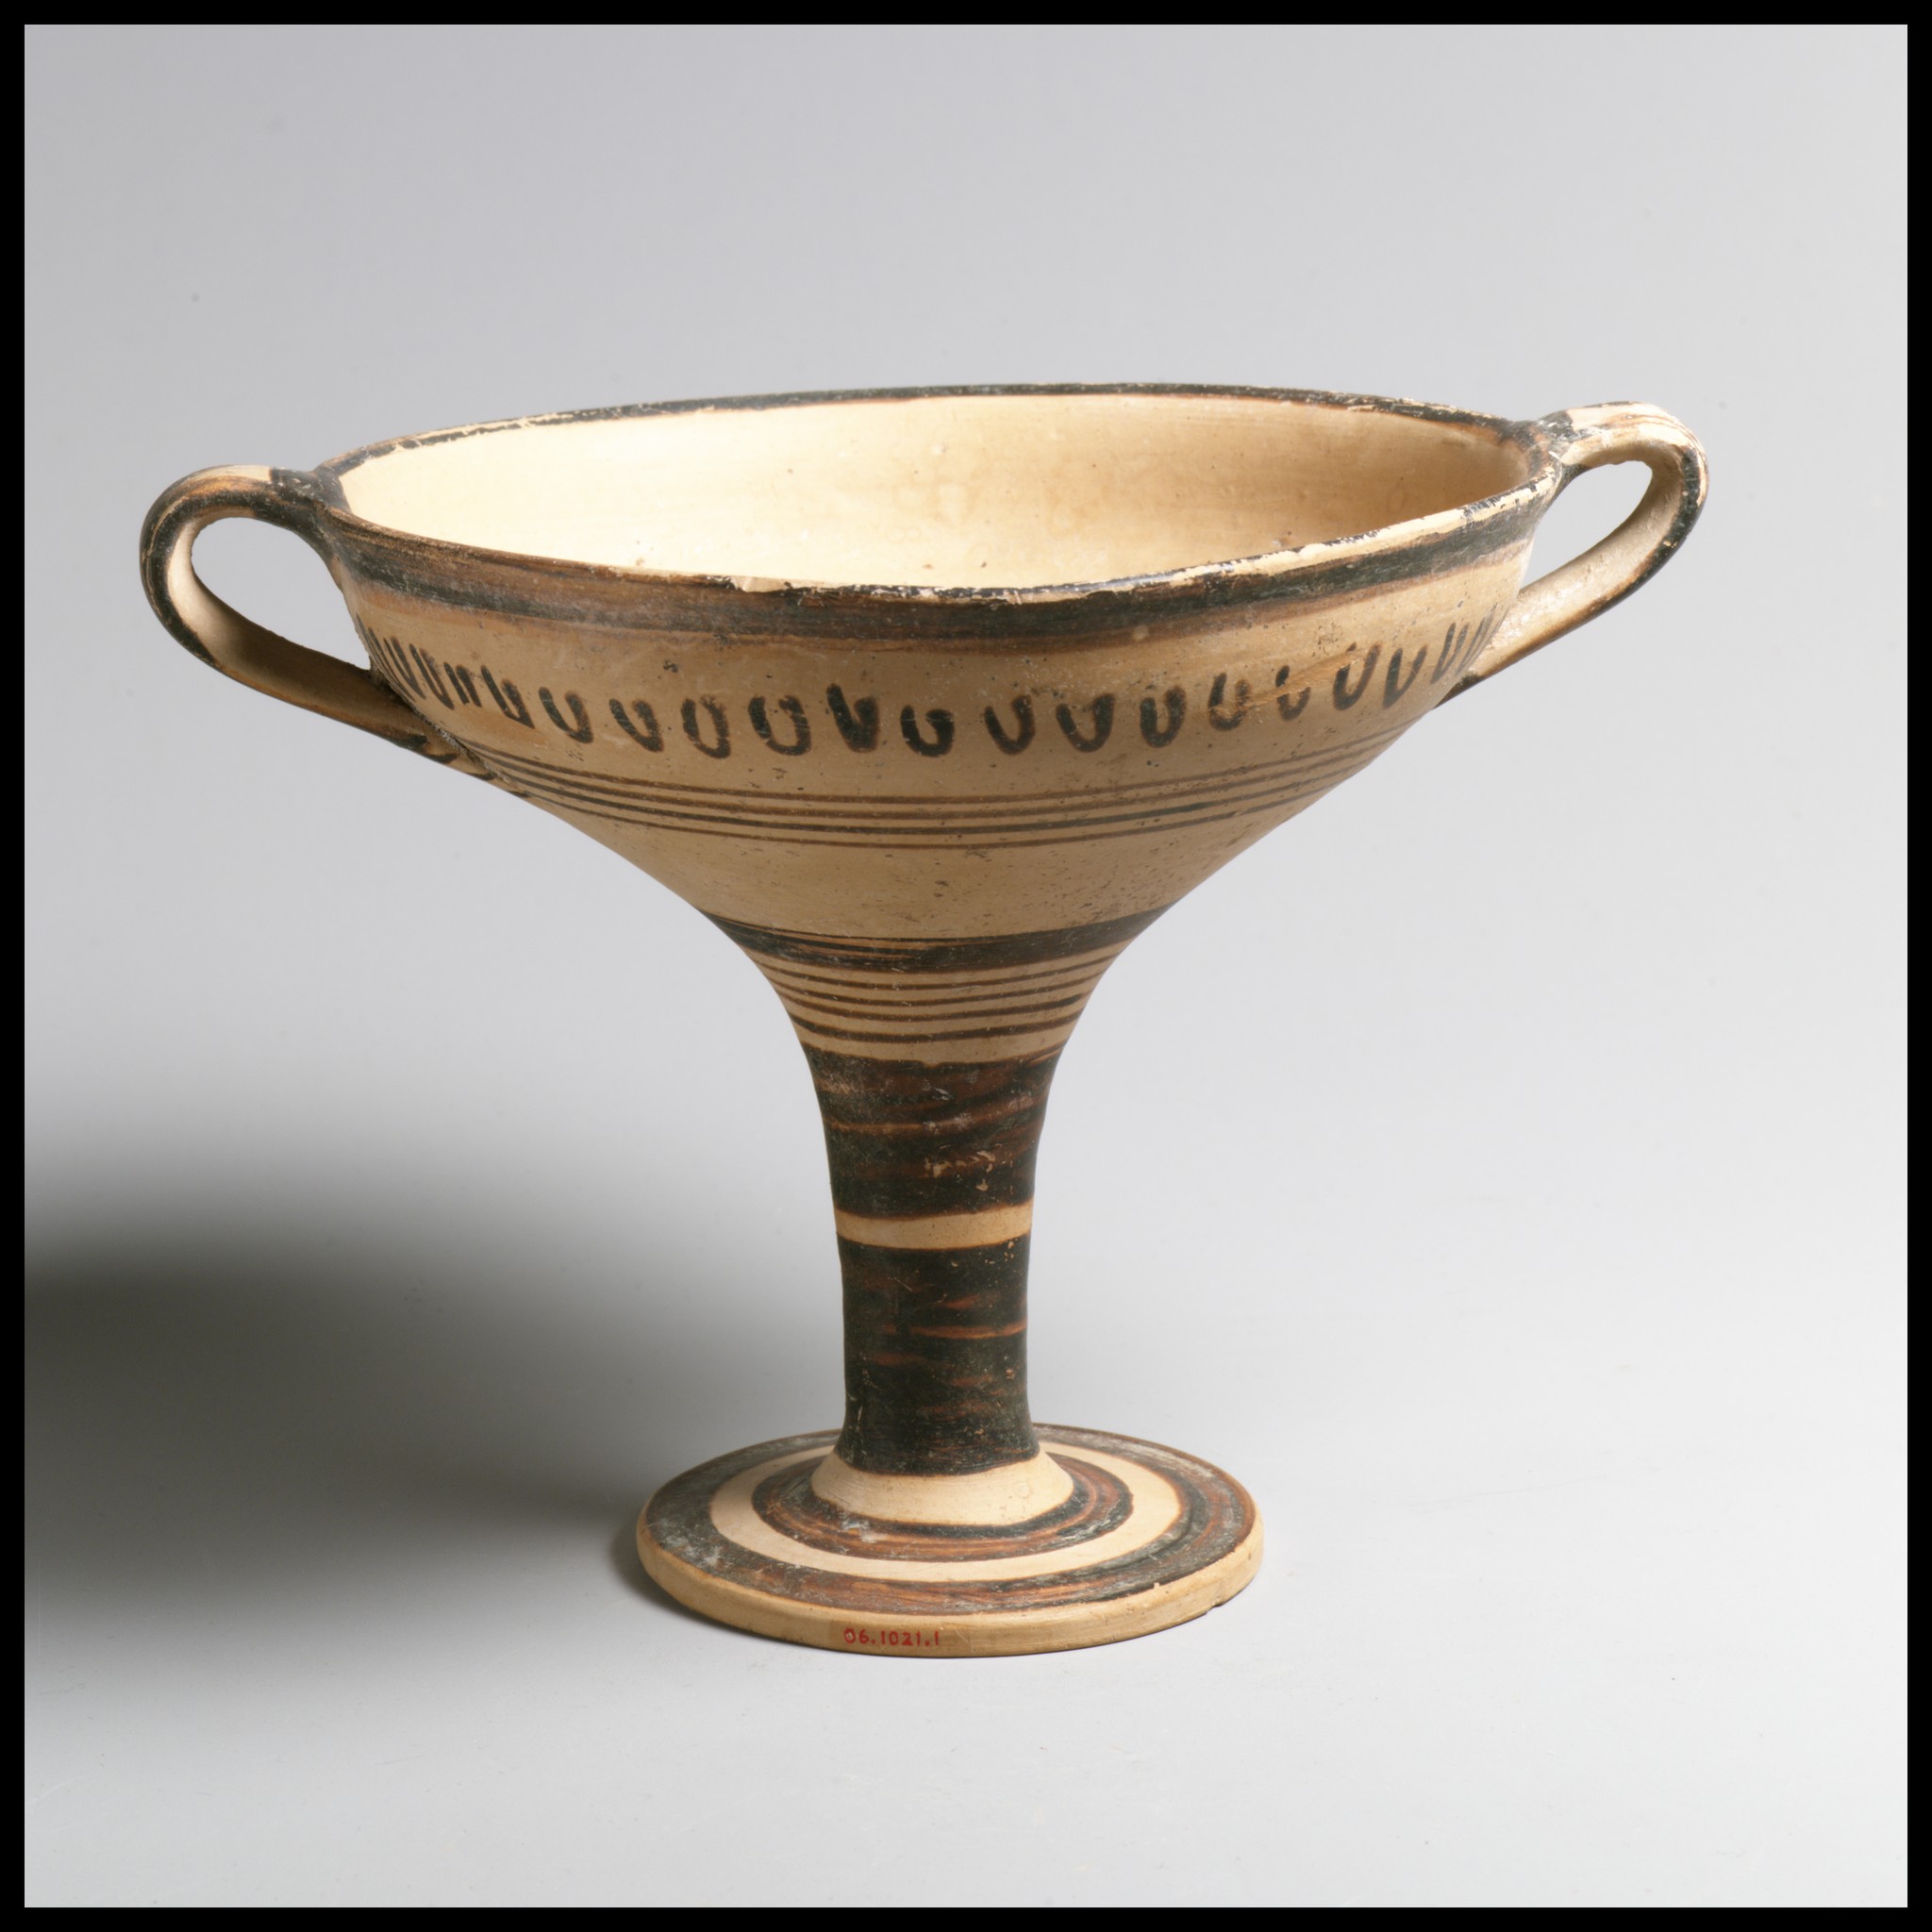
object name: cup, stemmed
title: Terracotta kylix (drinking cup)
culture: mycenaean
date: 1400-1050 BCE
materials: terracotta